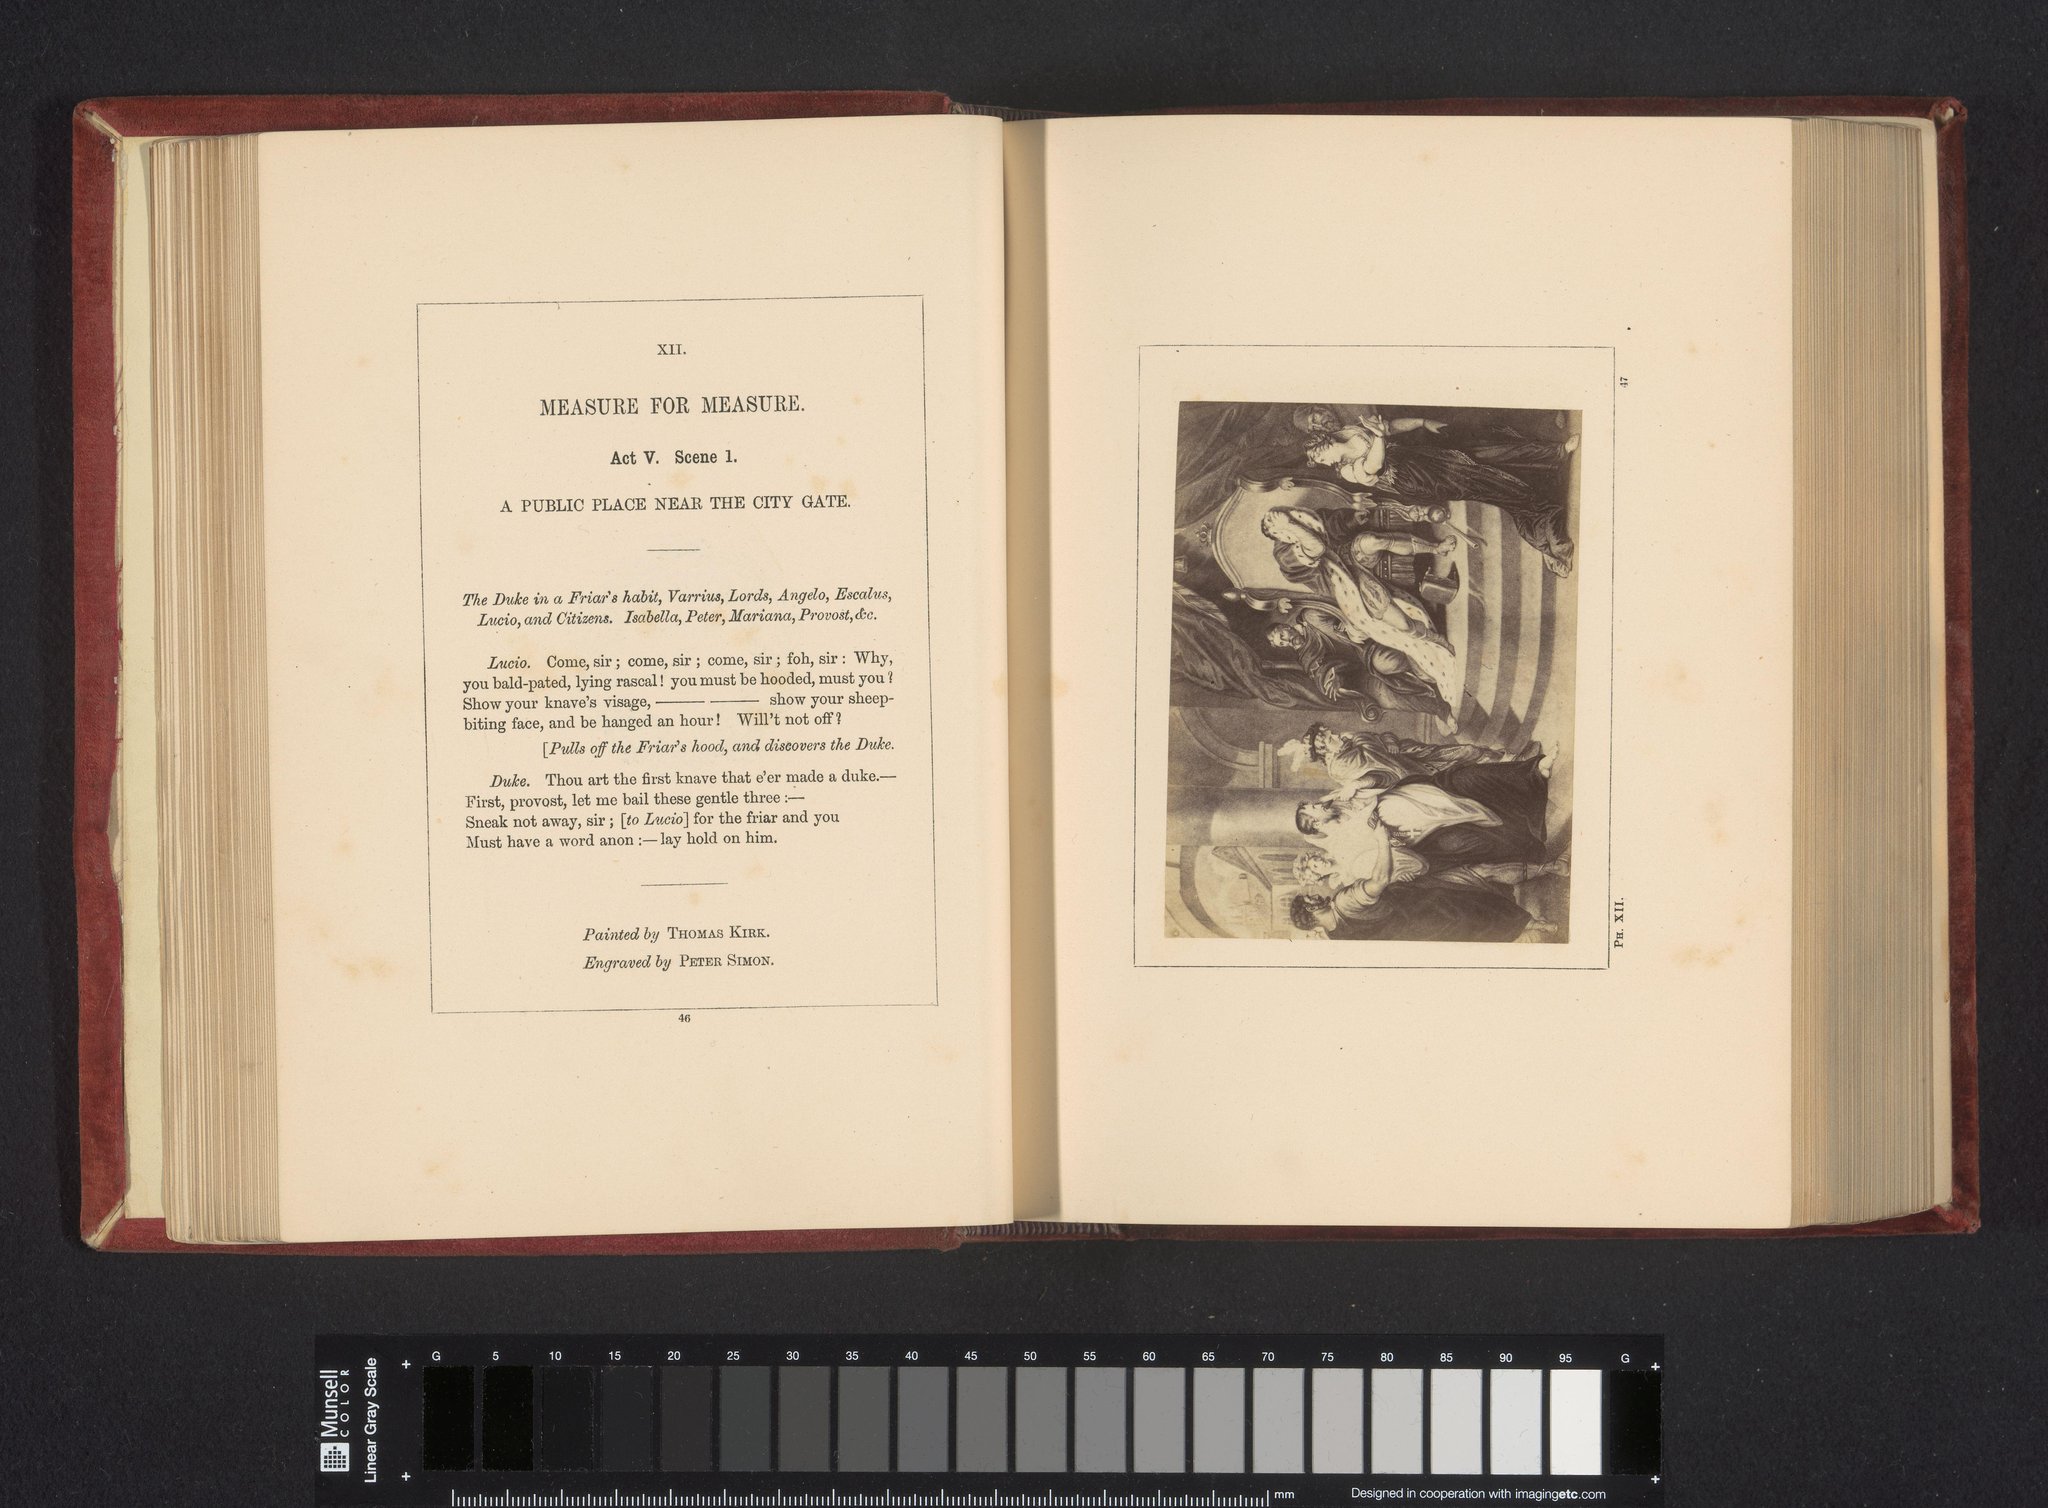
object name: page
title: Fotoreproductie van een prent naar een schilderij door Thomas Kir, voorstellend een scene uit Leer om leer door William Shakespeare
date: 1854-1864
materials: photographic support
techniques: albumen print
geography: london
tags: specific works of literature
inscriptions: number: ‘Ph. XII. 47’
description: Te zien is akte V, scene 1: De hertog zit op zijn troon met mensen ervoor.